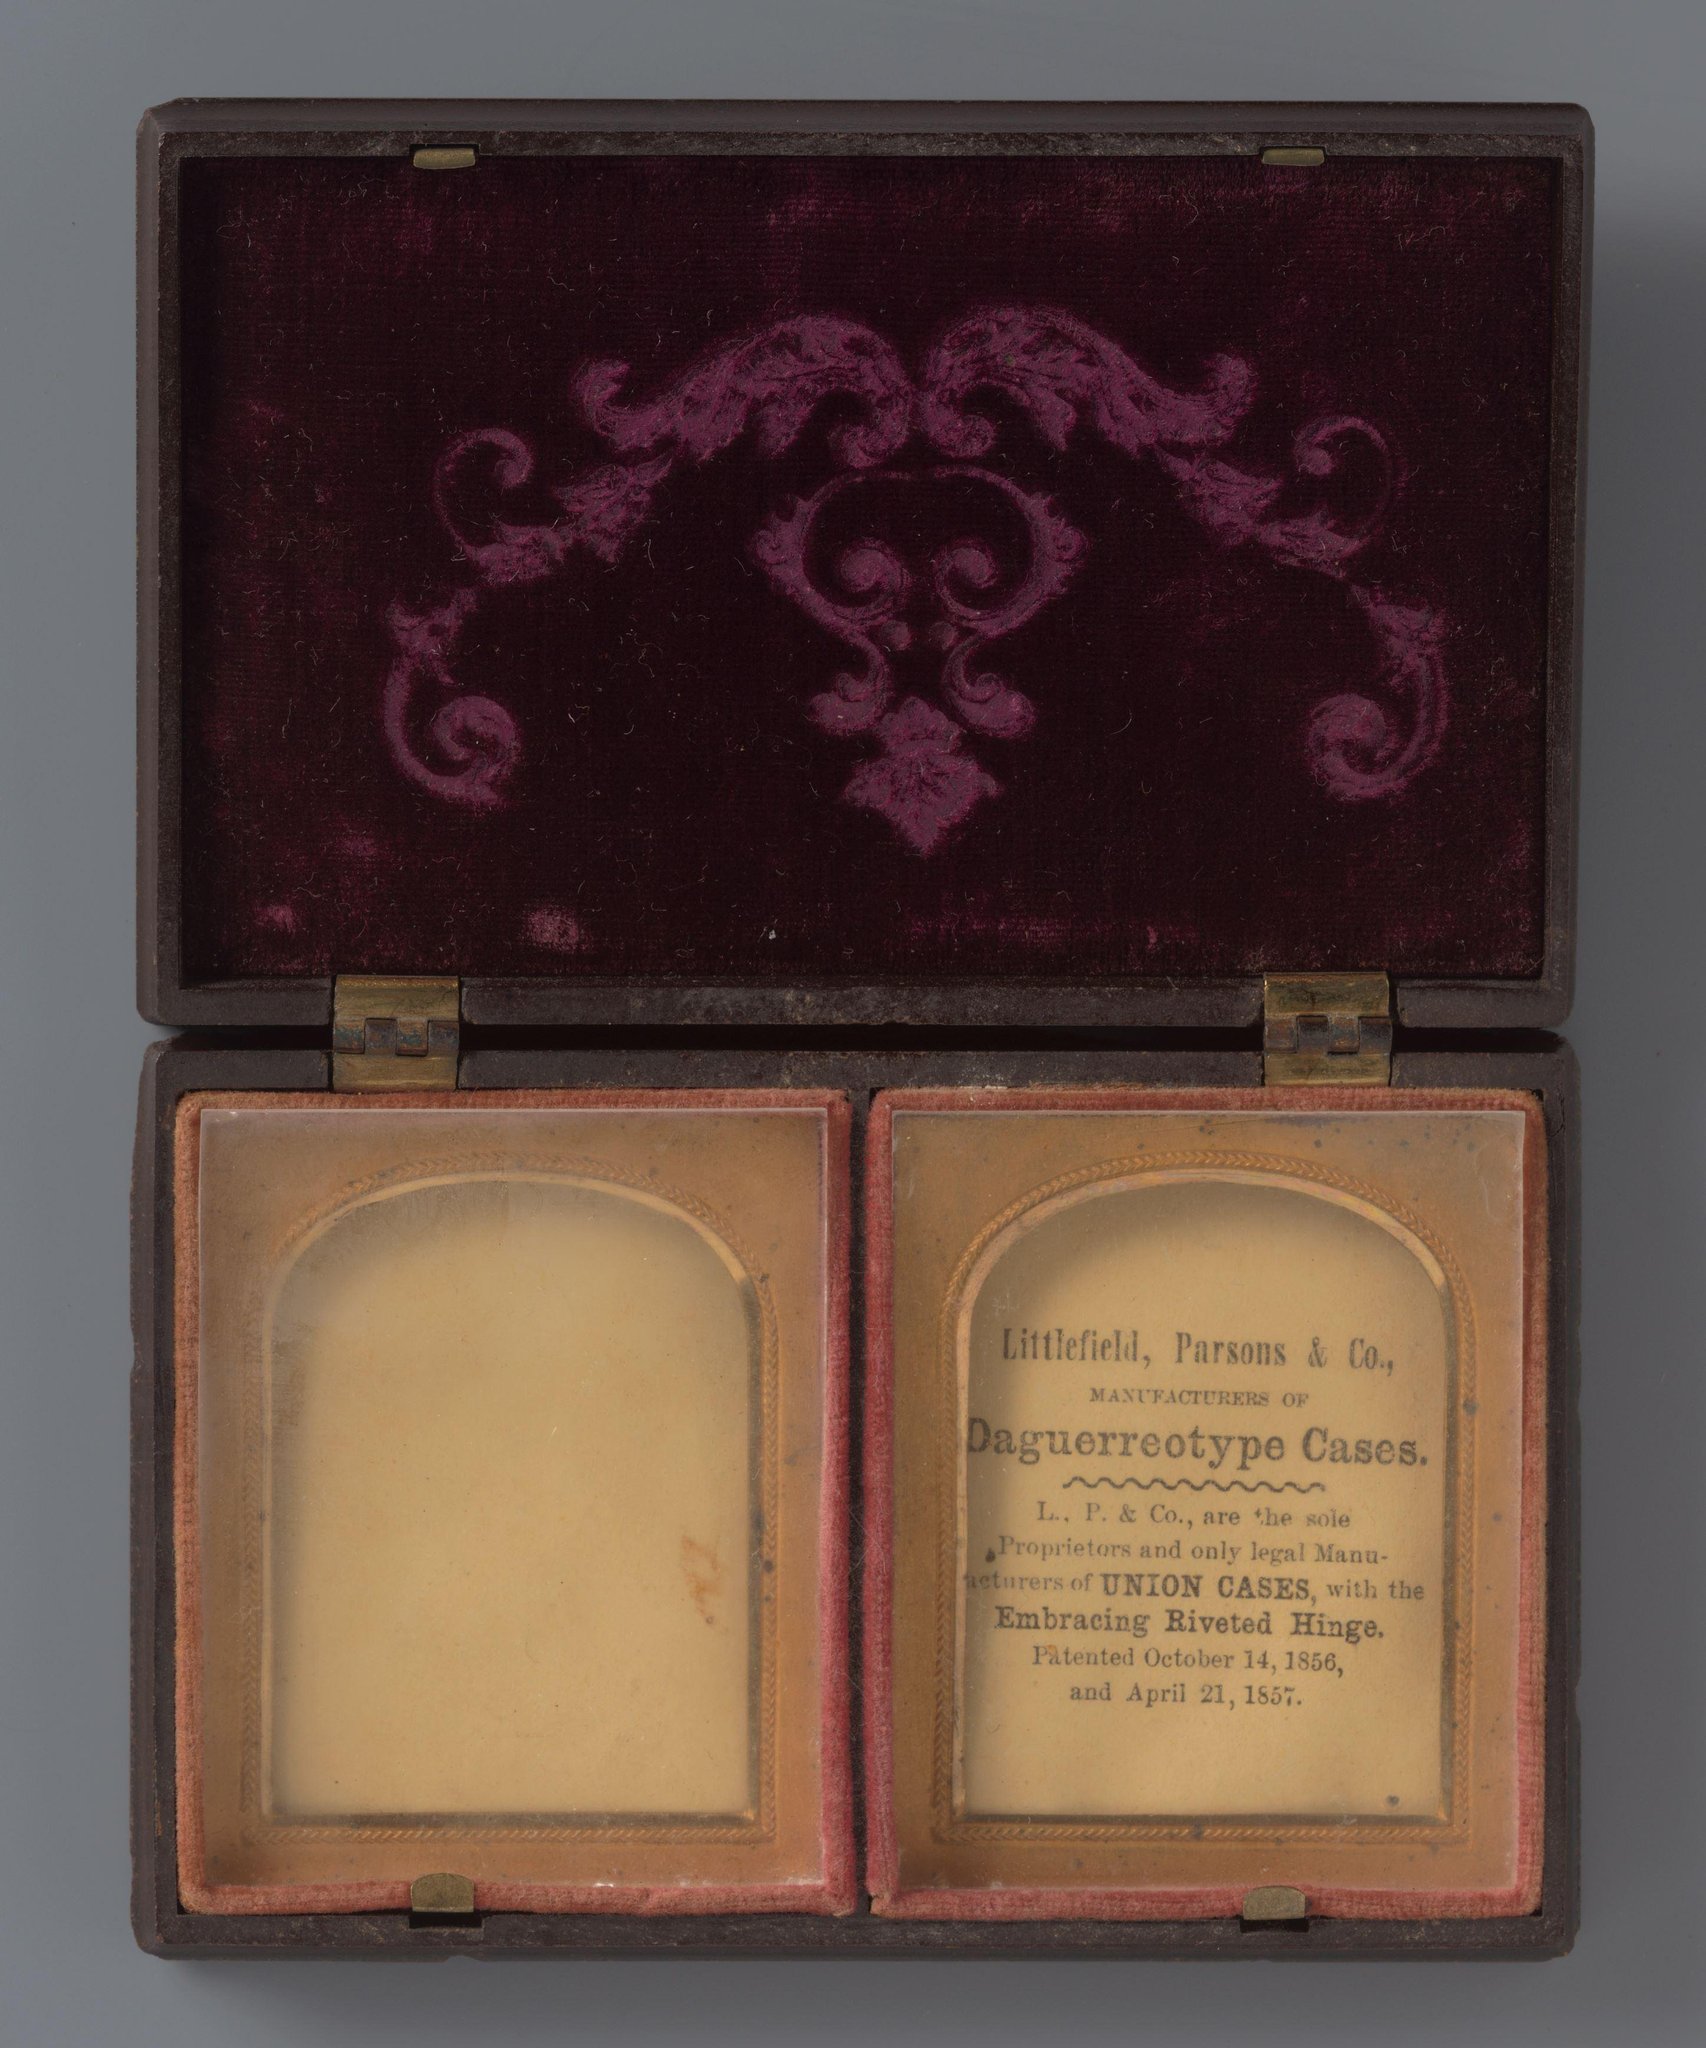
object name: union case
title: Union case (leeg)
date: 1860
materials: glass, metal, plastic, velvet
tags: children's games and plays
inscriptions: inscription: ‘Littlefield, Parsons & Co.,/manufacturers of/ Daguerreotype Cases./ L. P. & Co., are the sole/ Proprietors and only legal Manu-/ facturers of UNION CASES, with the/ Embracing Rivited Hinge./ Patented October 14, 1856,/ and April 21, 1857.’